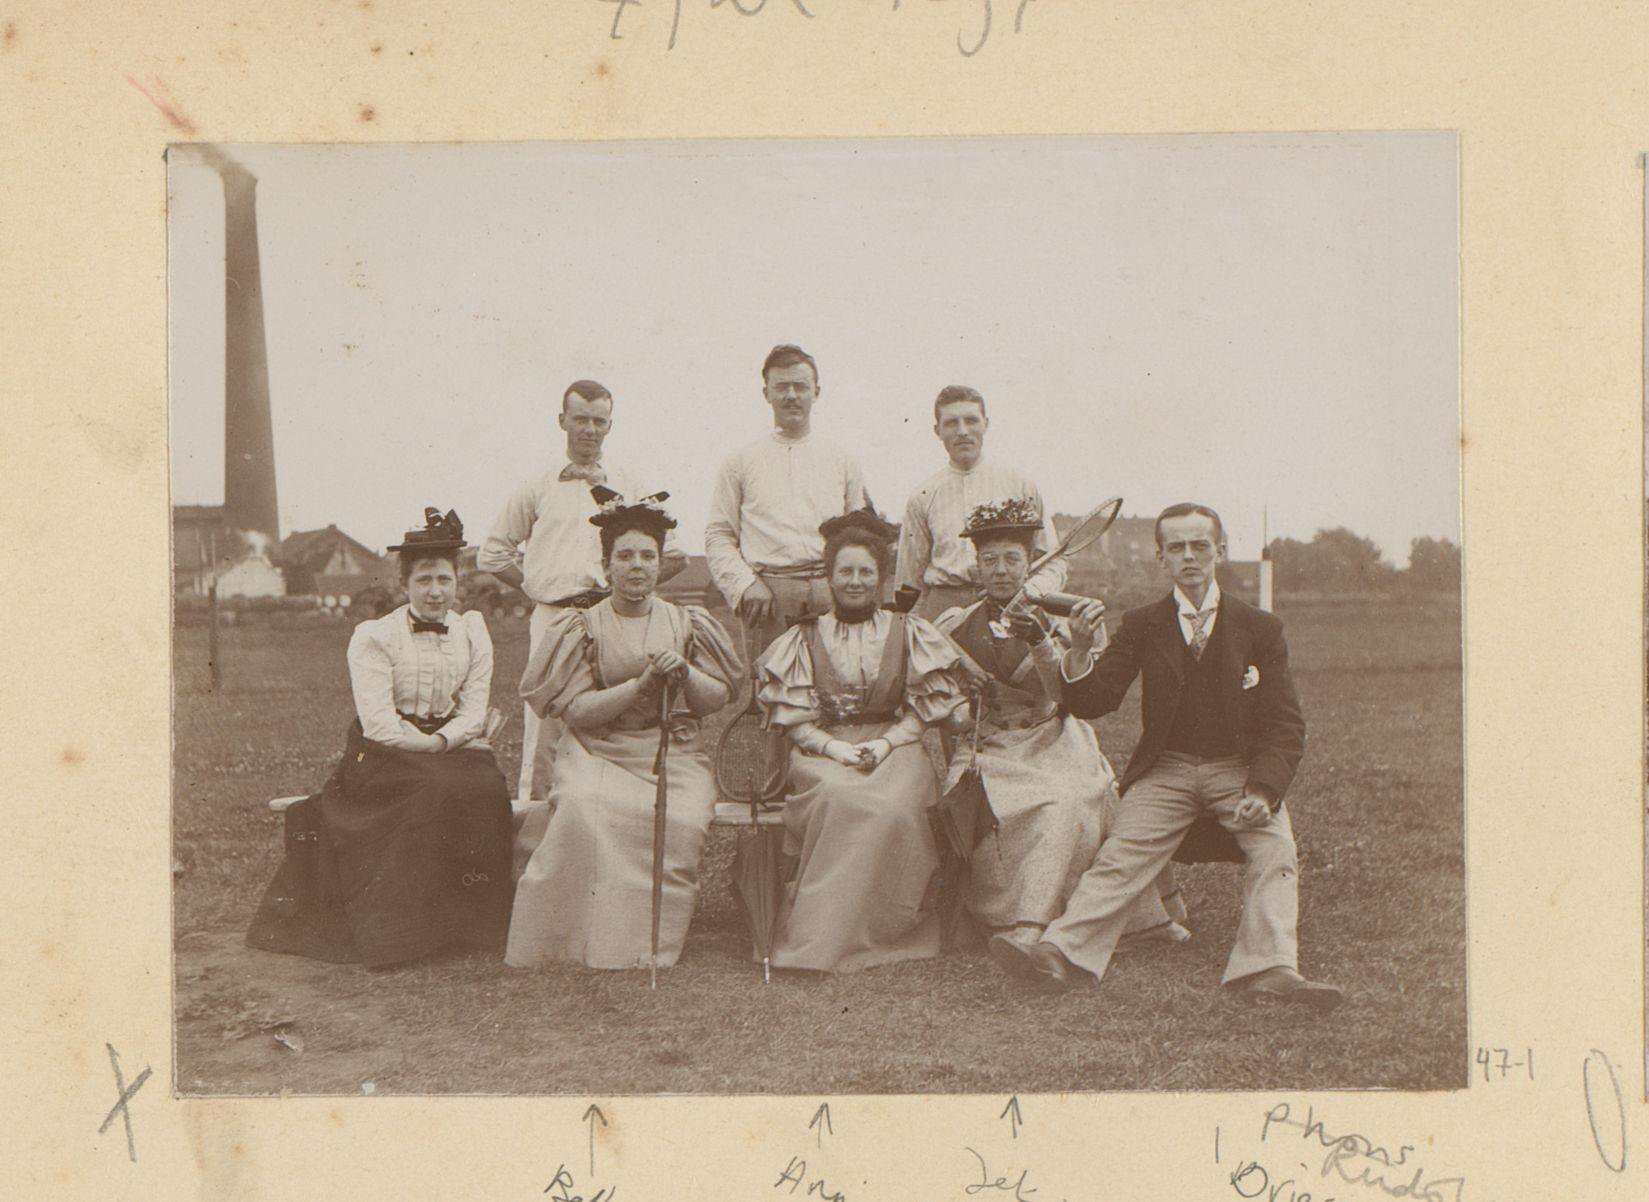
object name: photograph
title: Groepsportret in weiland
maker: hendrik herman van den berg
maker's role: amateurfotograaf, jurist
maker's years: 1875-1944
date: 1894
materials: paper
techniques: collodion silver print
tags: utrecht, batavia, historical persons, amsterdam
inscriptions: caption: ‘Belle, Annie, Jet van Schmid, Rudolph Driessen, Linie [?] kleyn’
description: Foto 1 op albumblad 47 uit album "Amsterdam 1890-1894".